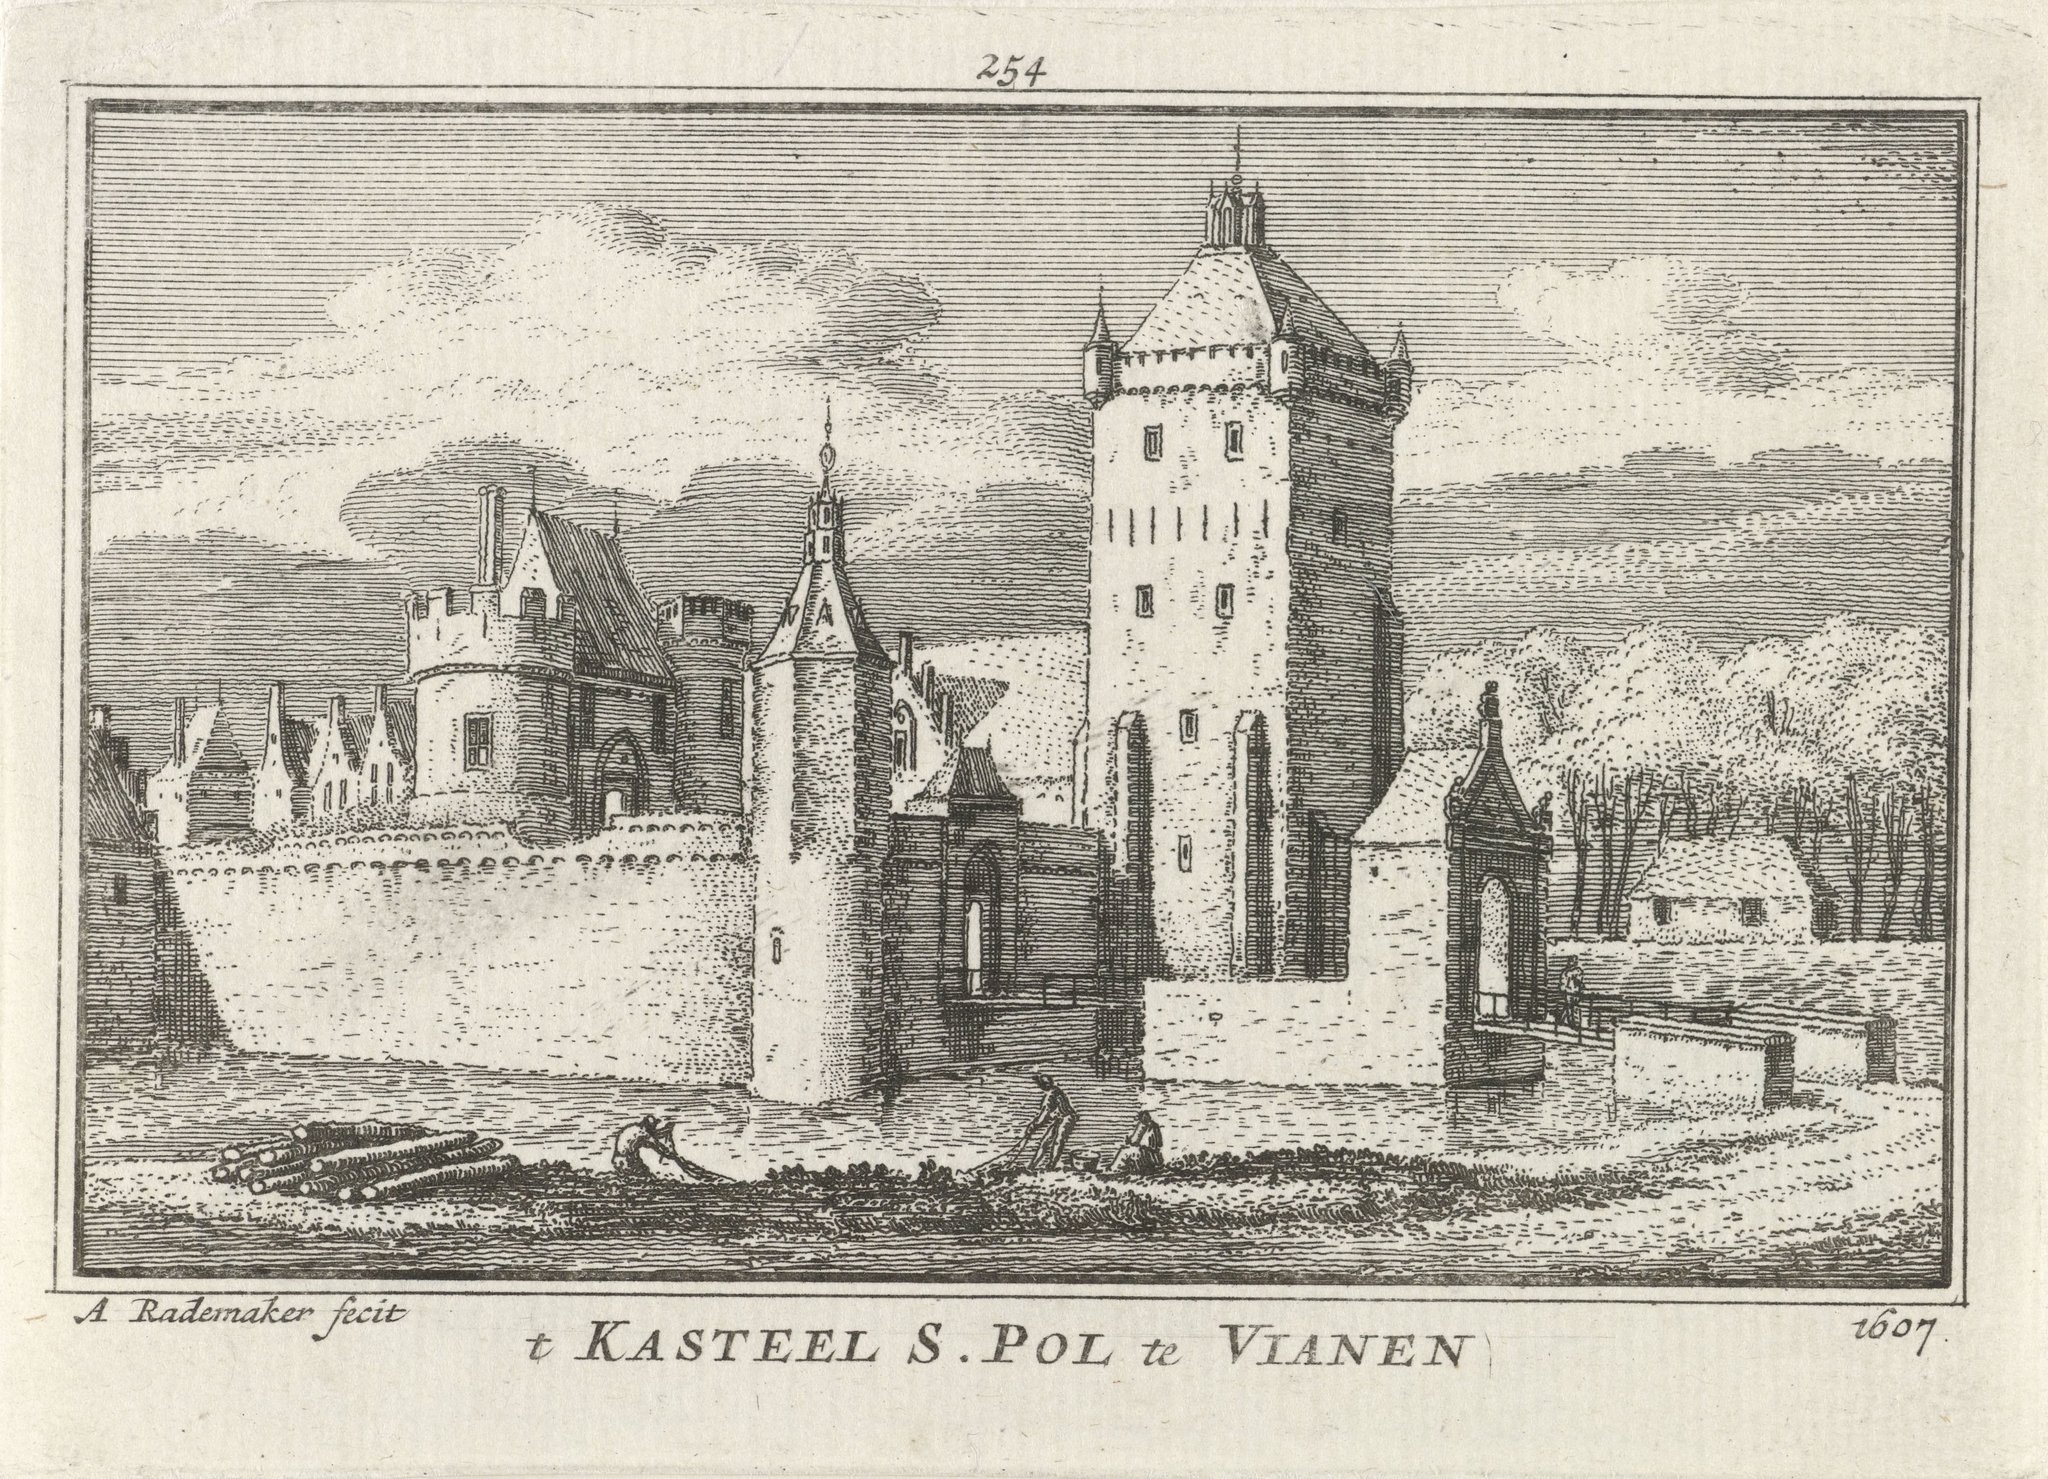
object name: book illustration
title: Kasteel S. Pol te Vianen 1607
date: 1727-1733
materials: paper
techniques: etching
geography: amsterdam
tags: castle, woodcutting, woodcutter ~ forestry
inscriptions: collector's mark: Lugt 2228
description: Illustratie uit: Abraham Rademaker, Matthaeus Brouërius van Niedek, Isaac Le Long, Kabinet van Nederlandsche en Kleefsche outheden en (...) voorname stads- en landgebouwen, Willem Barents en Antoni Schoonenburg: Amsterdam, 1727-1733, ill. nr. 254.